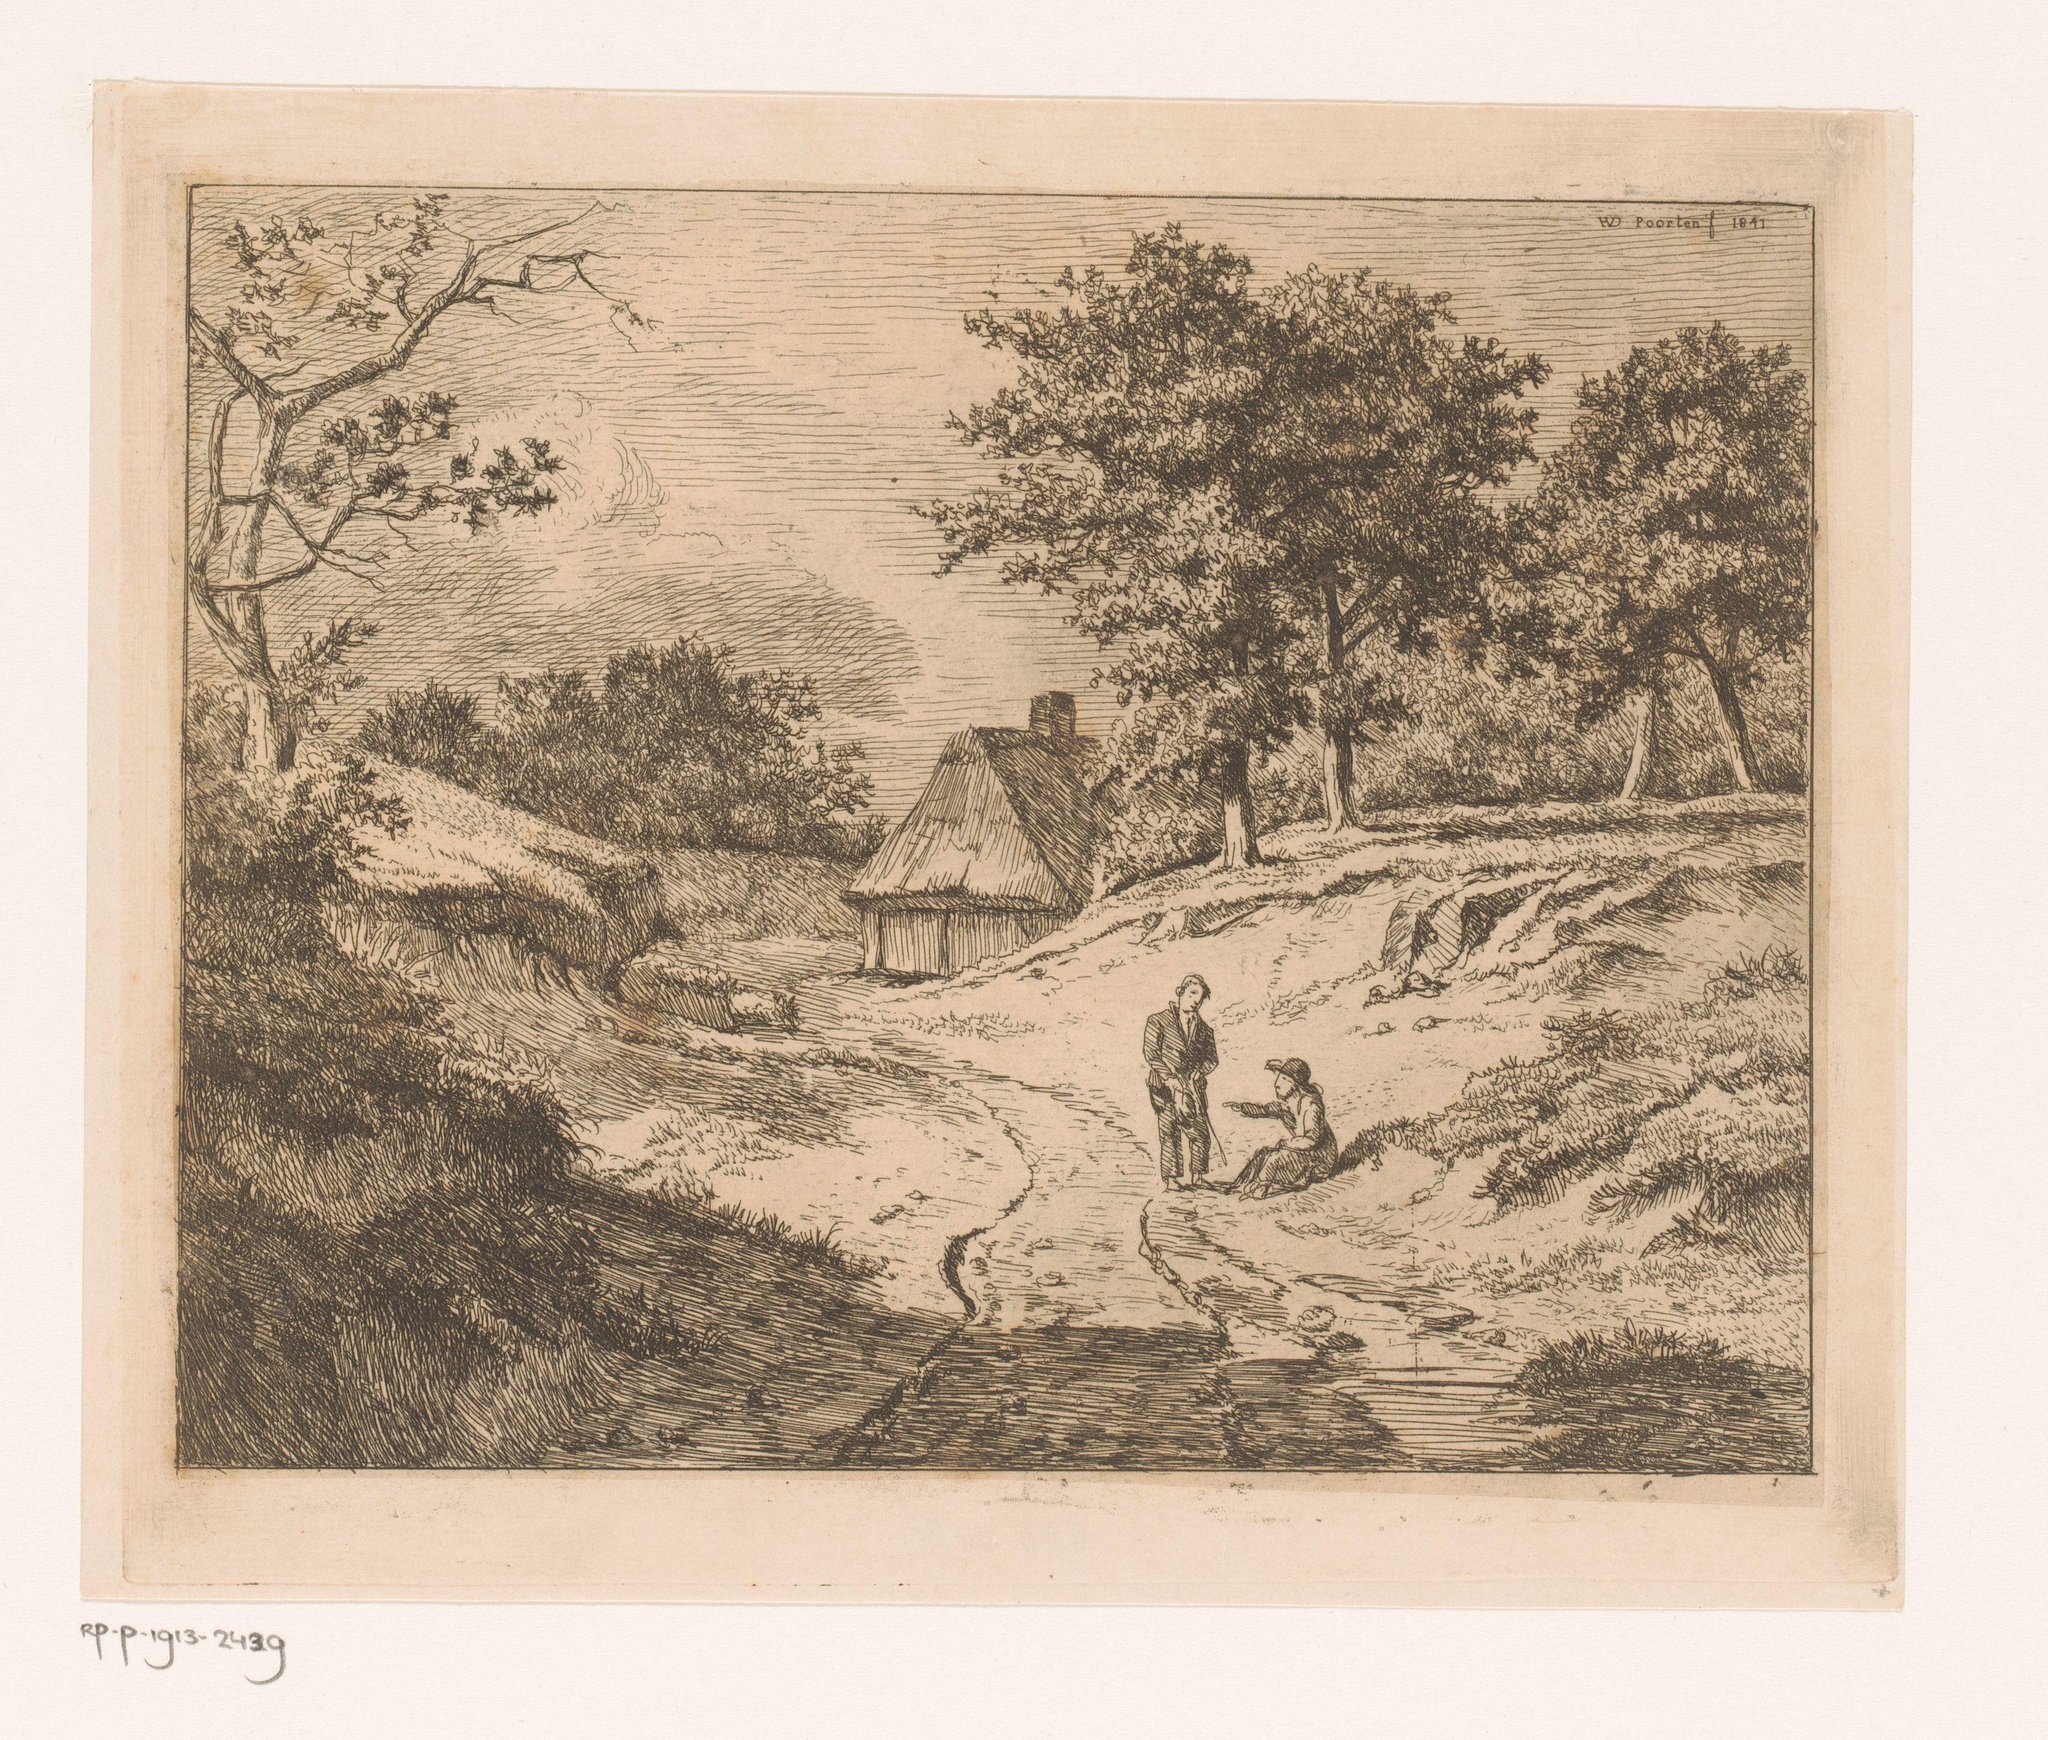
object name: print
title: Landschap met persoon die een ander de weg wijst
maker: hendrik jozef franciscus van der poorten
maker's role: draughtsman, print maker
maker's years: 1789-1874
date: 1841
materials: paper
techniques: drypoint, etching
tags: farm or solitary house in landscape, asking the way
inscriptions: collector's mark: Lugt 1485, collector's mark: Lugt 2228